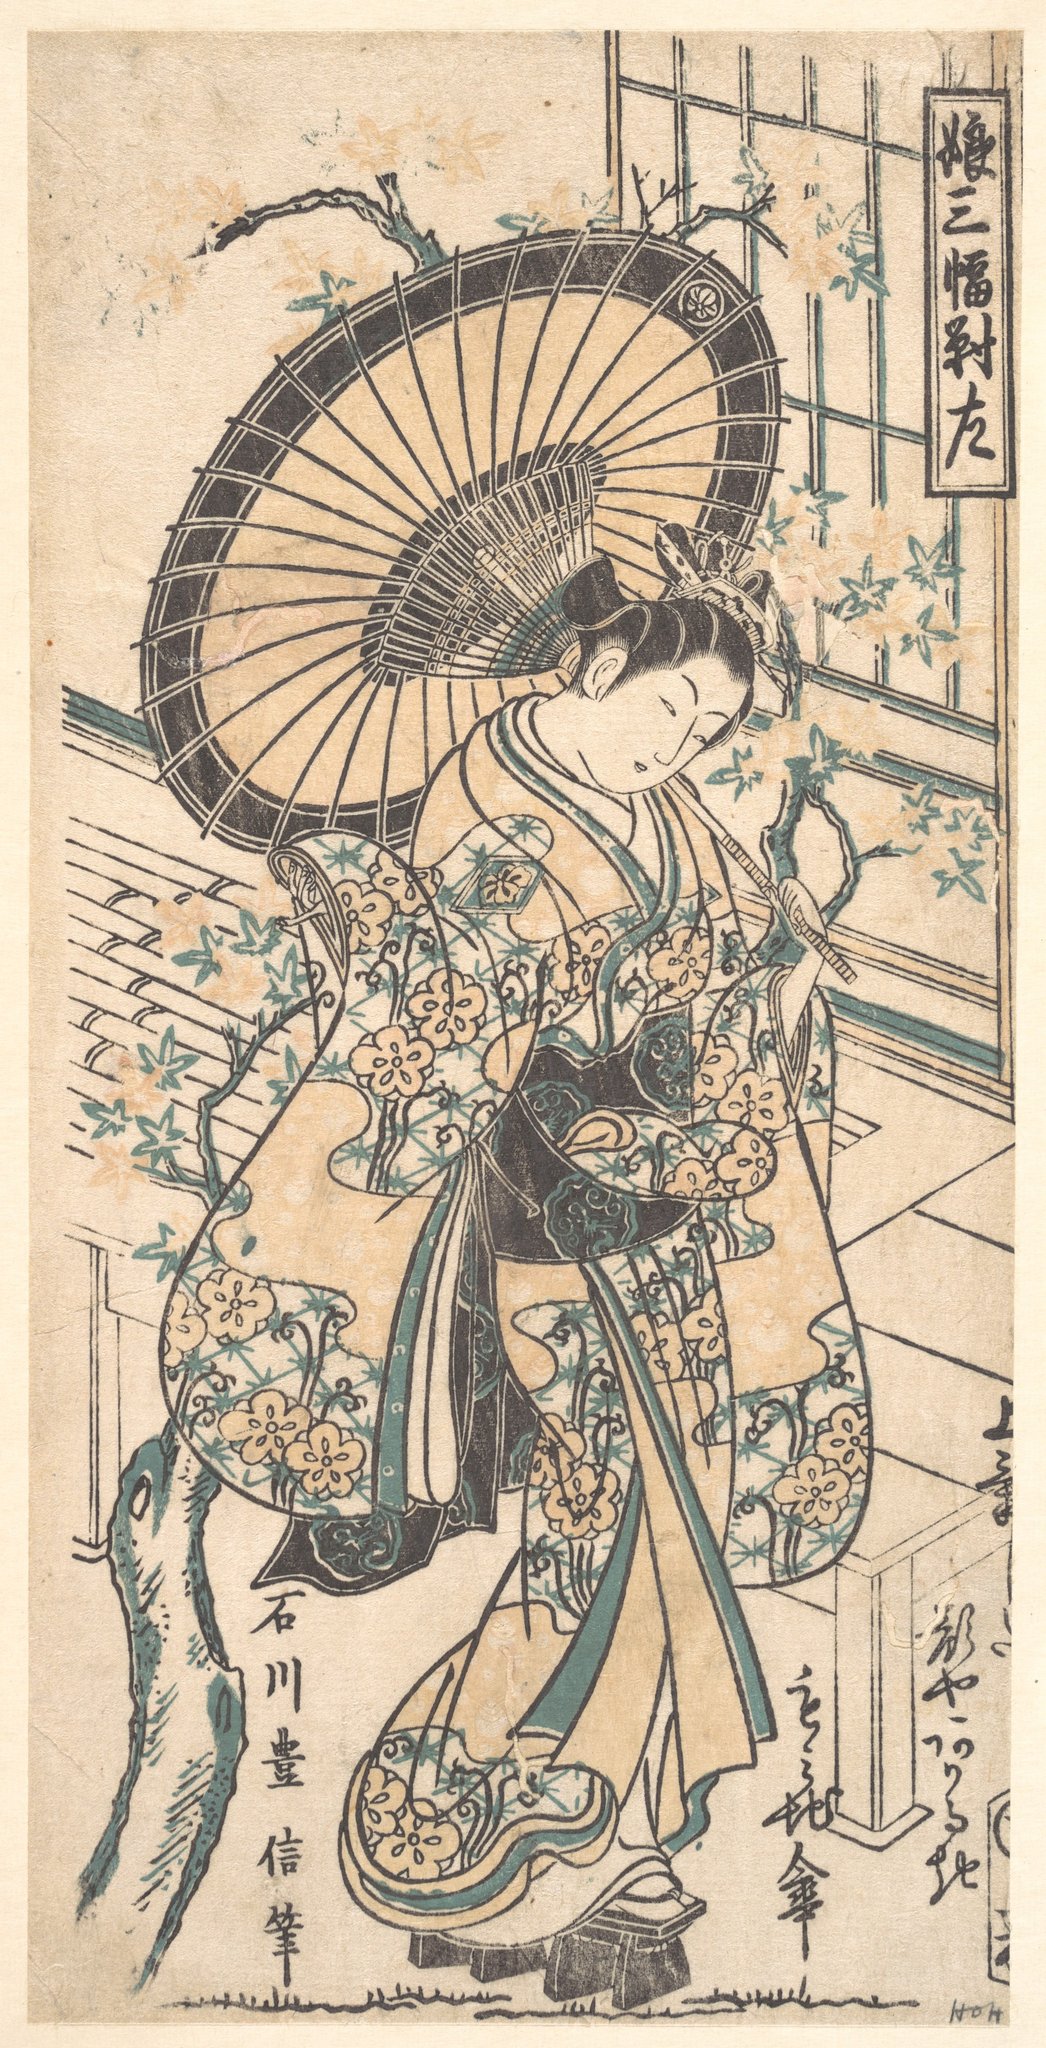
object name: print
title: Young Lady with Parasol in the Yoshiwara District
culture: japanese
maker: ishikawa toyonobu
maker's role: artist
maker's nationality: japanese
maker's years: 1711-1785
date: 1711-1785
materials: ink, paper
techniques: woodblock print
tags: women,parasols